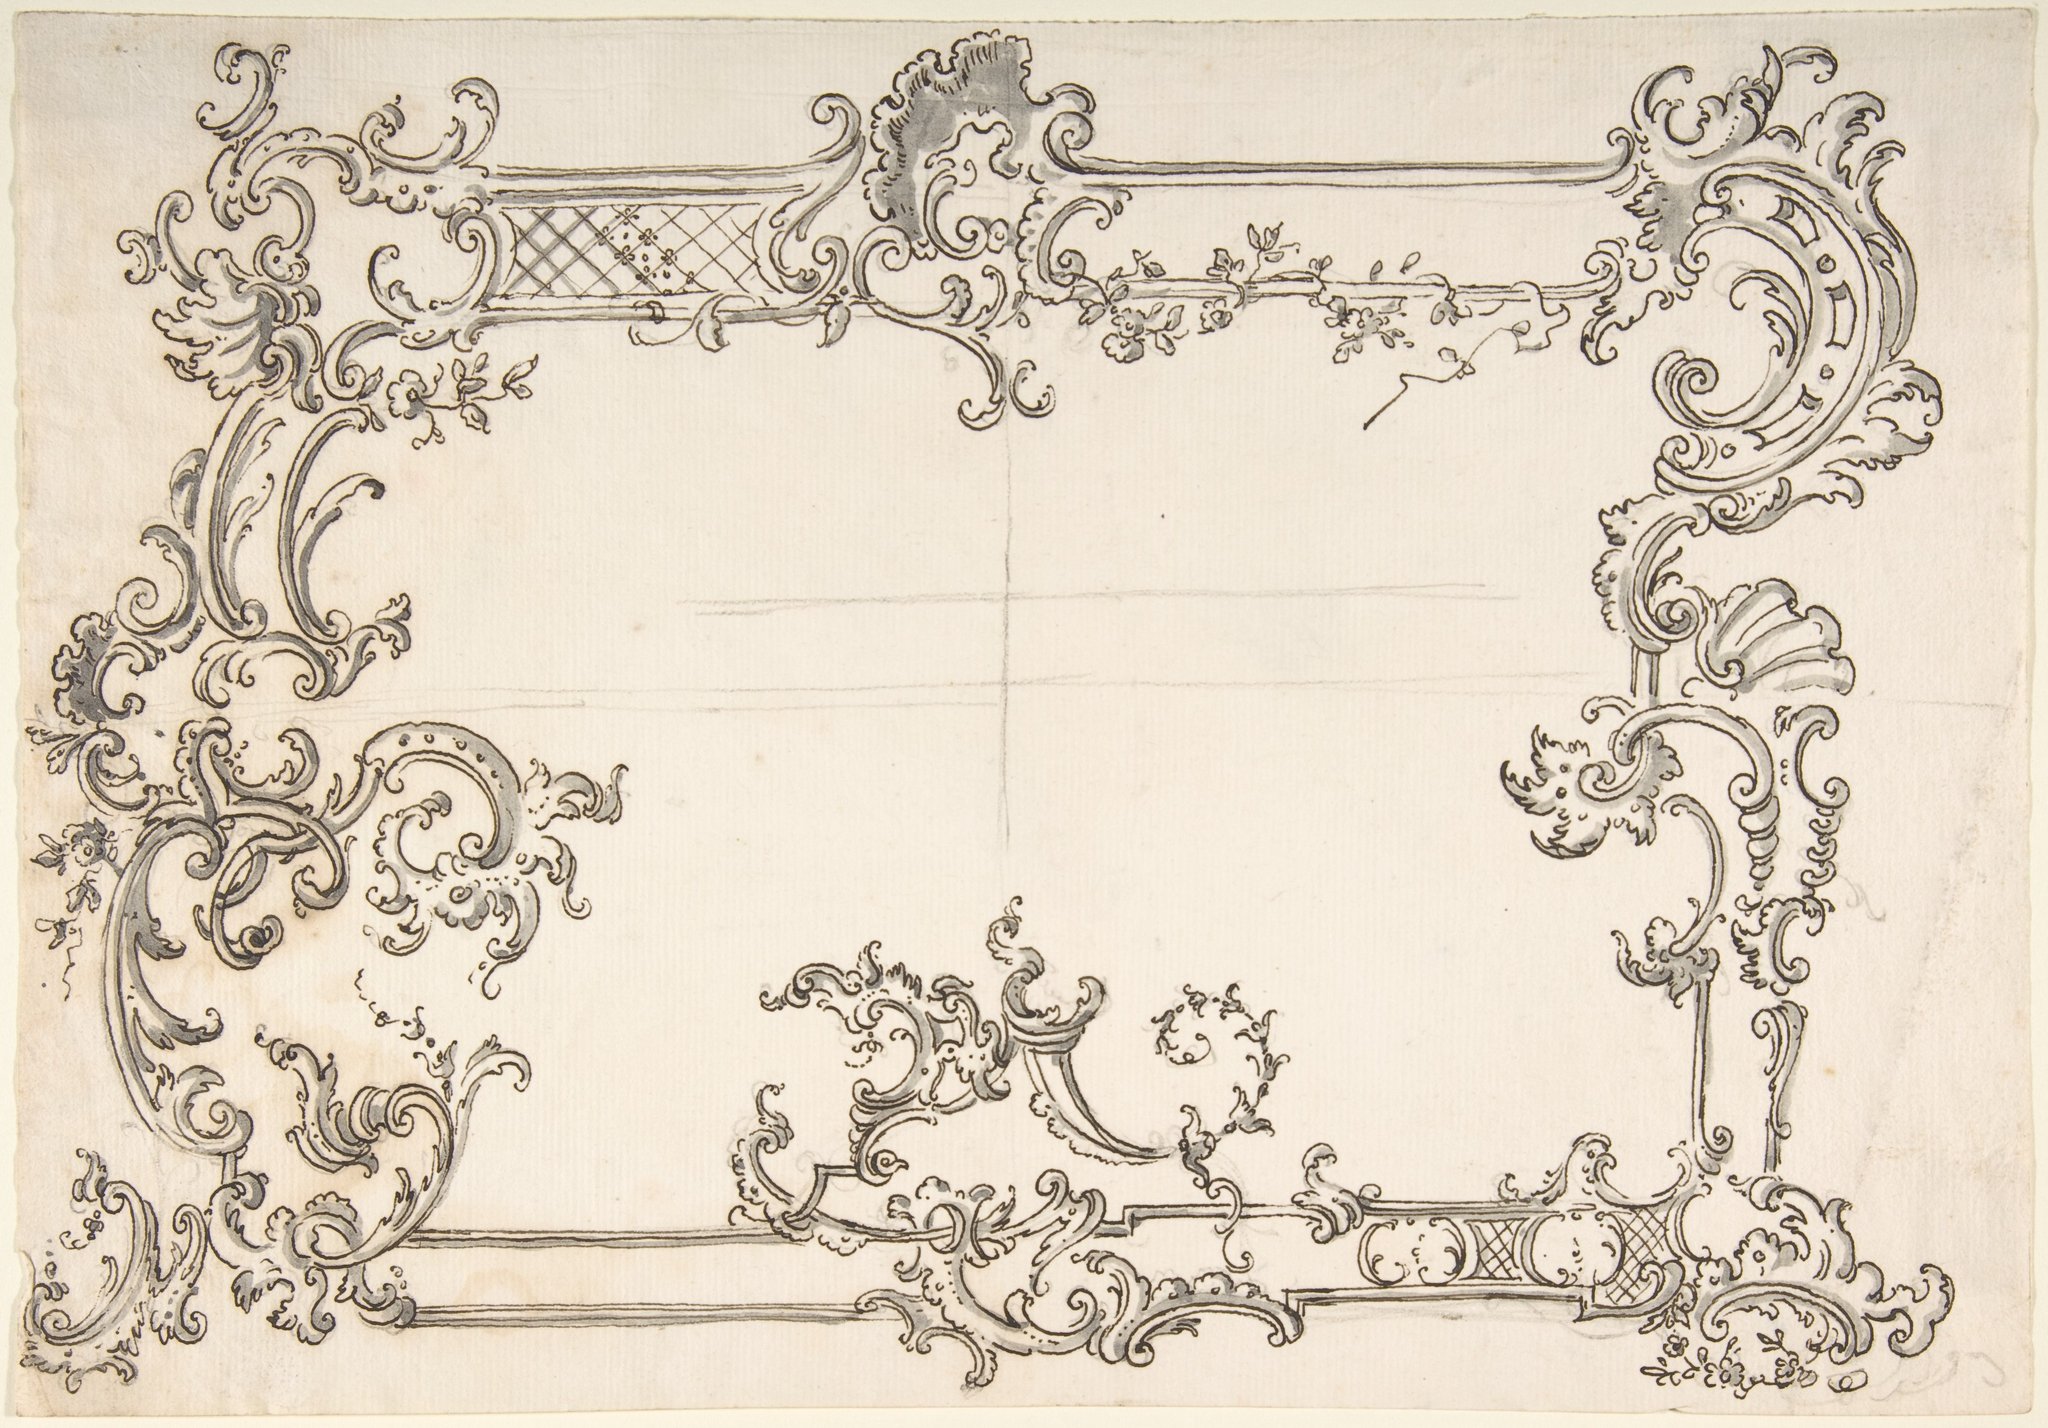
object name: drawing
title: Rococo Design for a Frame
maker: anonymous, italian, 18th century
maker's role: artist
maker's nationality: italian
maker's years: 1700-1800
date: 1701-1800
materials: ink, pencil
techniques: pen, wash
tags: ornament